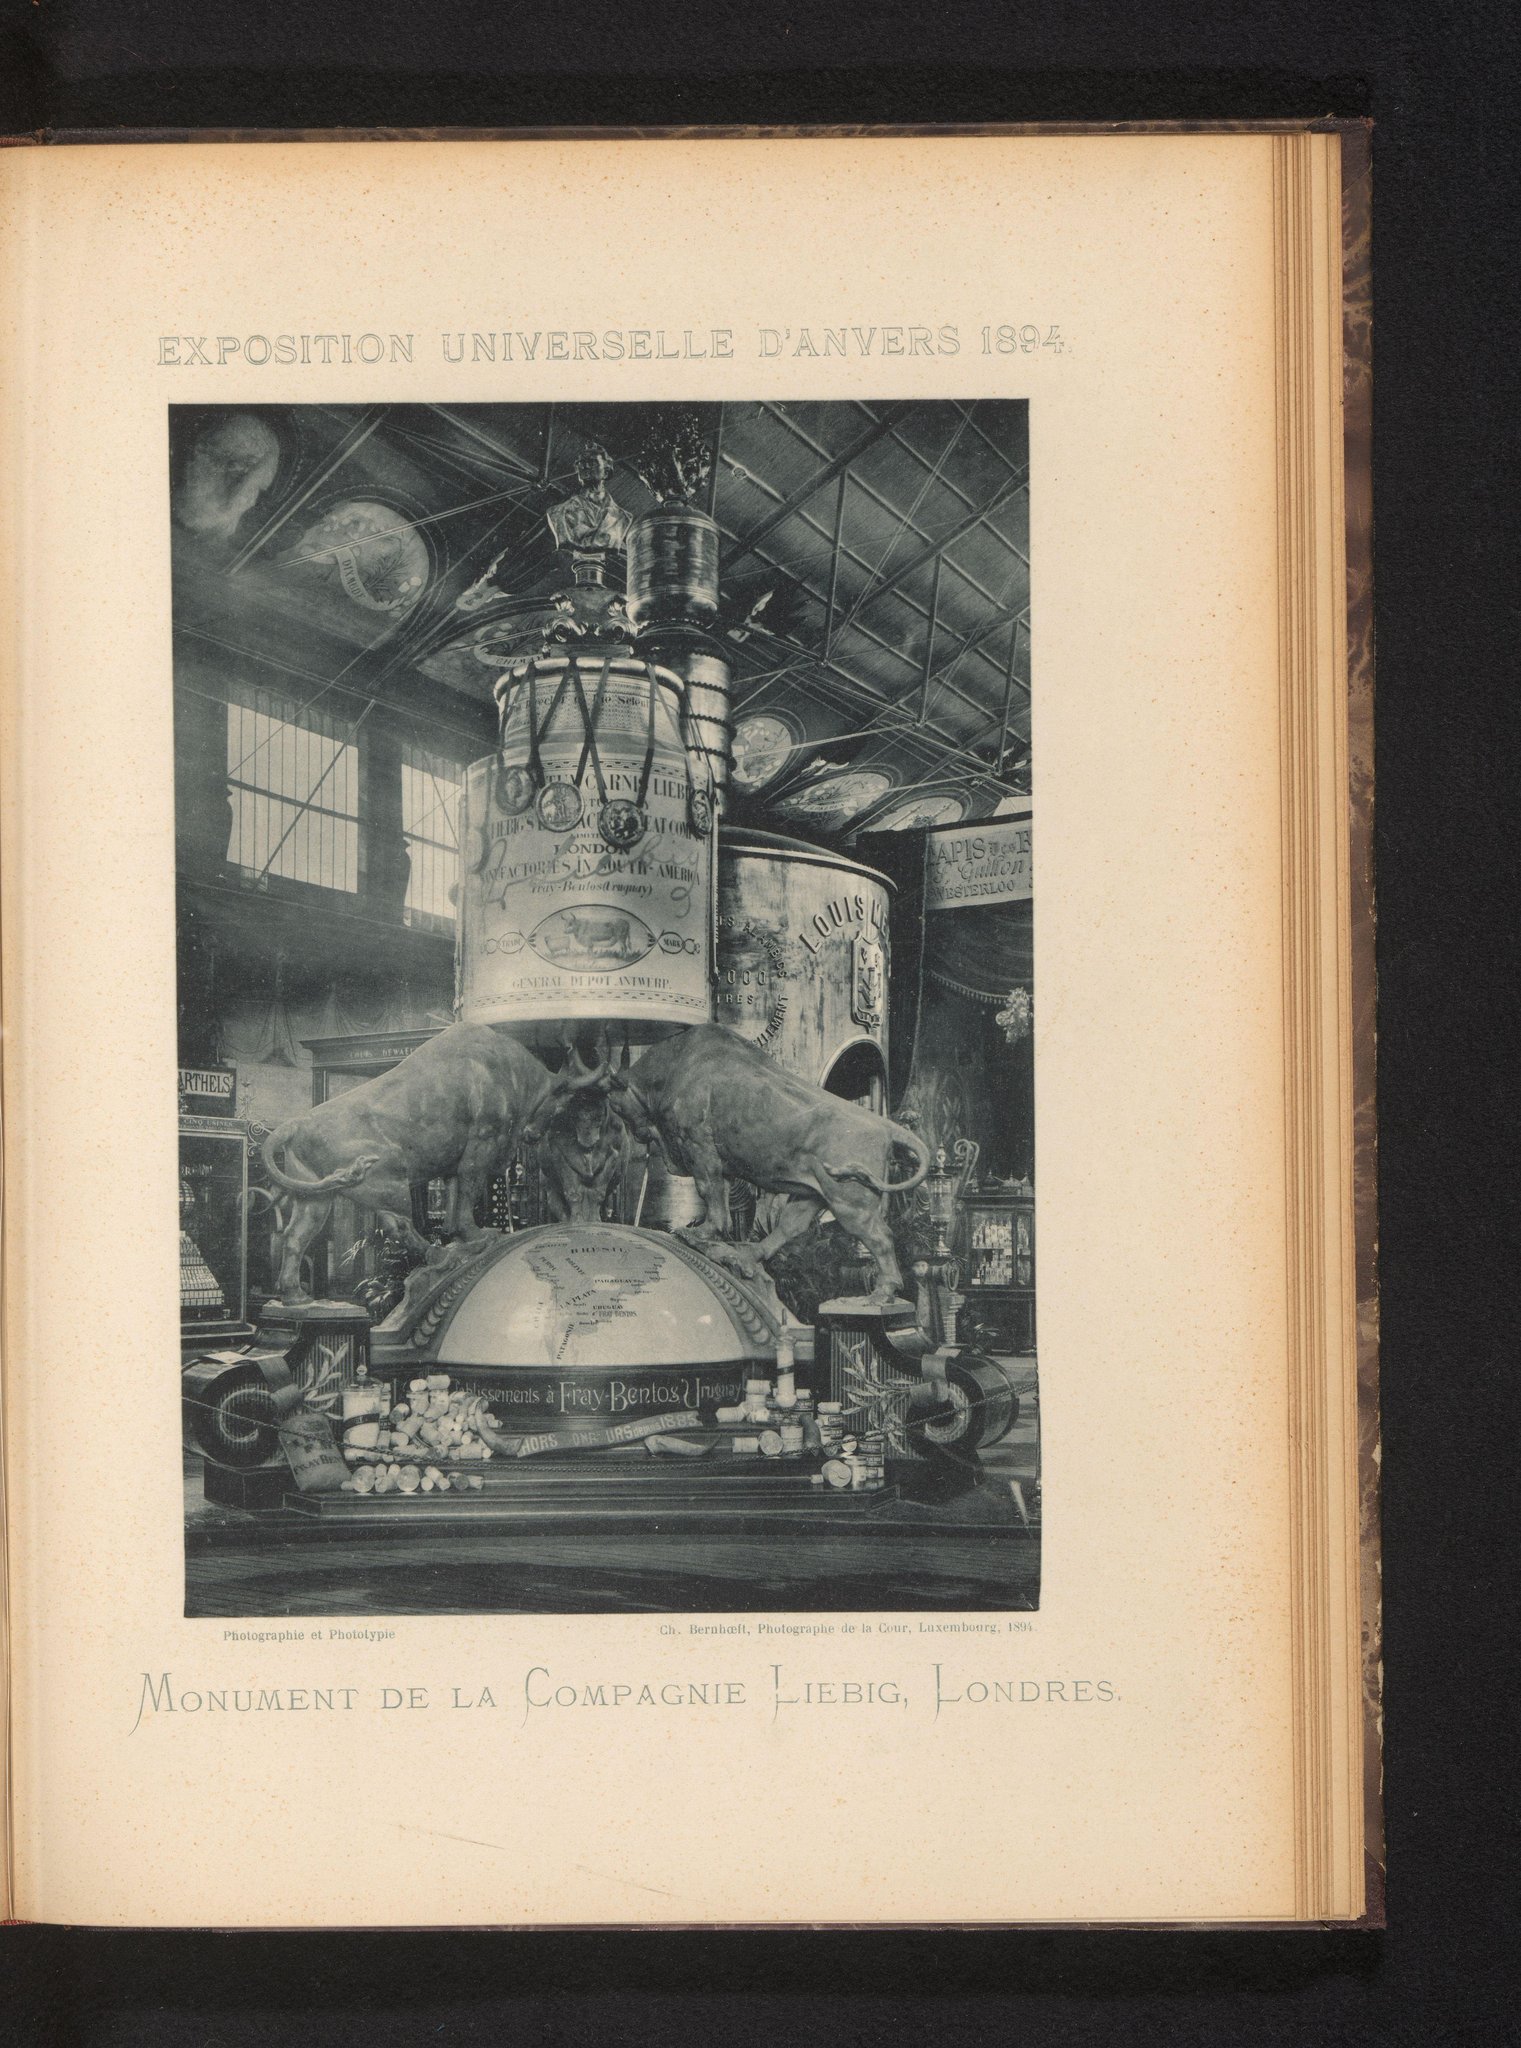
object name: page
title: Monument voor de Liebig Extract of Meat Company op de Wereldtentoonstelling van Antwerpen in 1894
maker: charles bernhoeft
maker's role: publisher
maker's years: 1859-1933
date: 1894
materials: paper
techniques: photograph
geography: luxembourg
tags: bull, world fair, world exhibition, monument, statue, antwerp